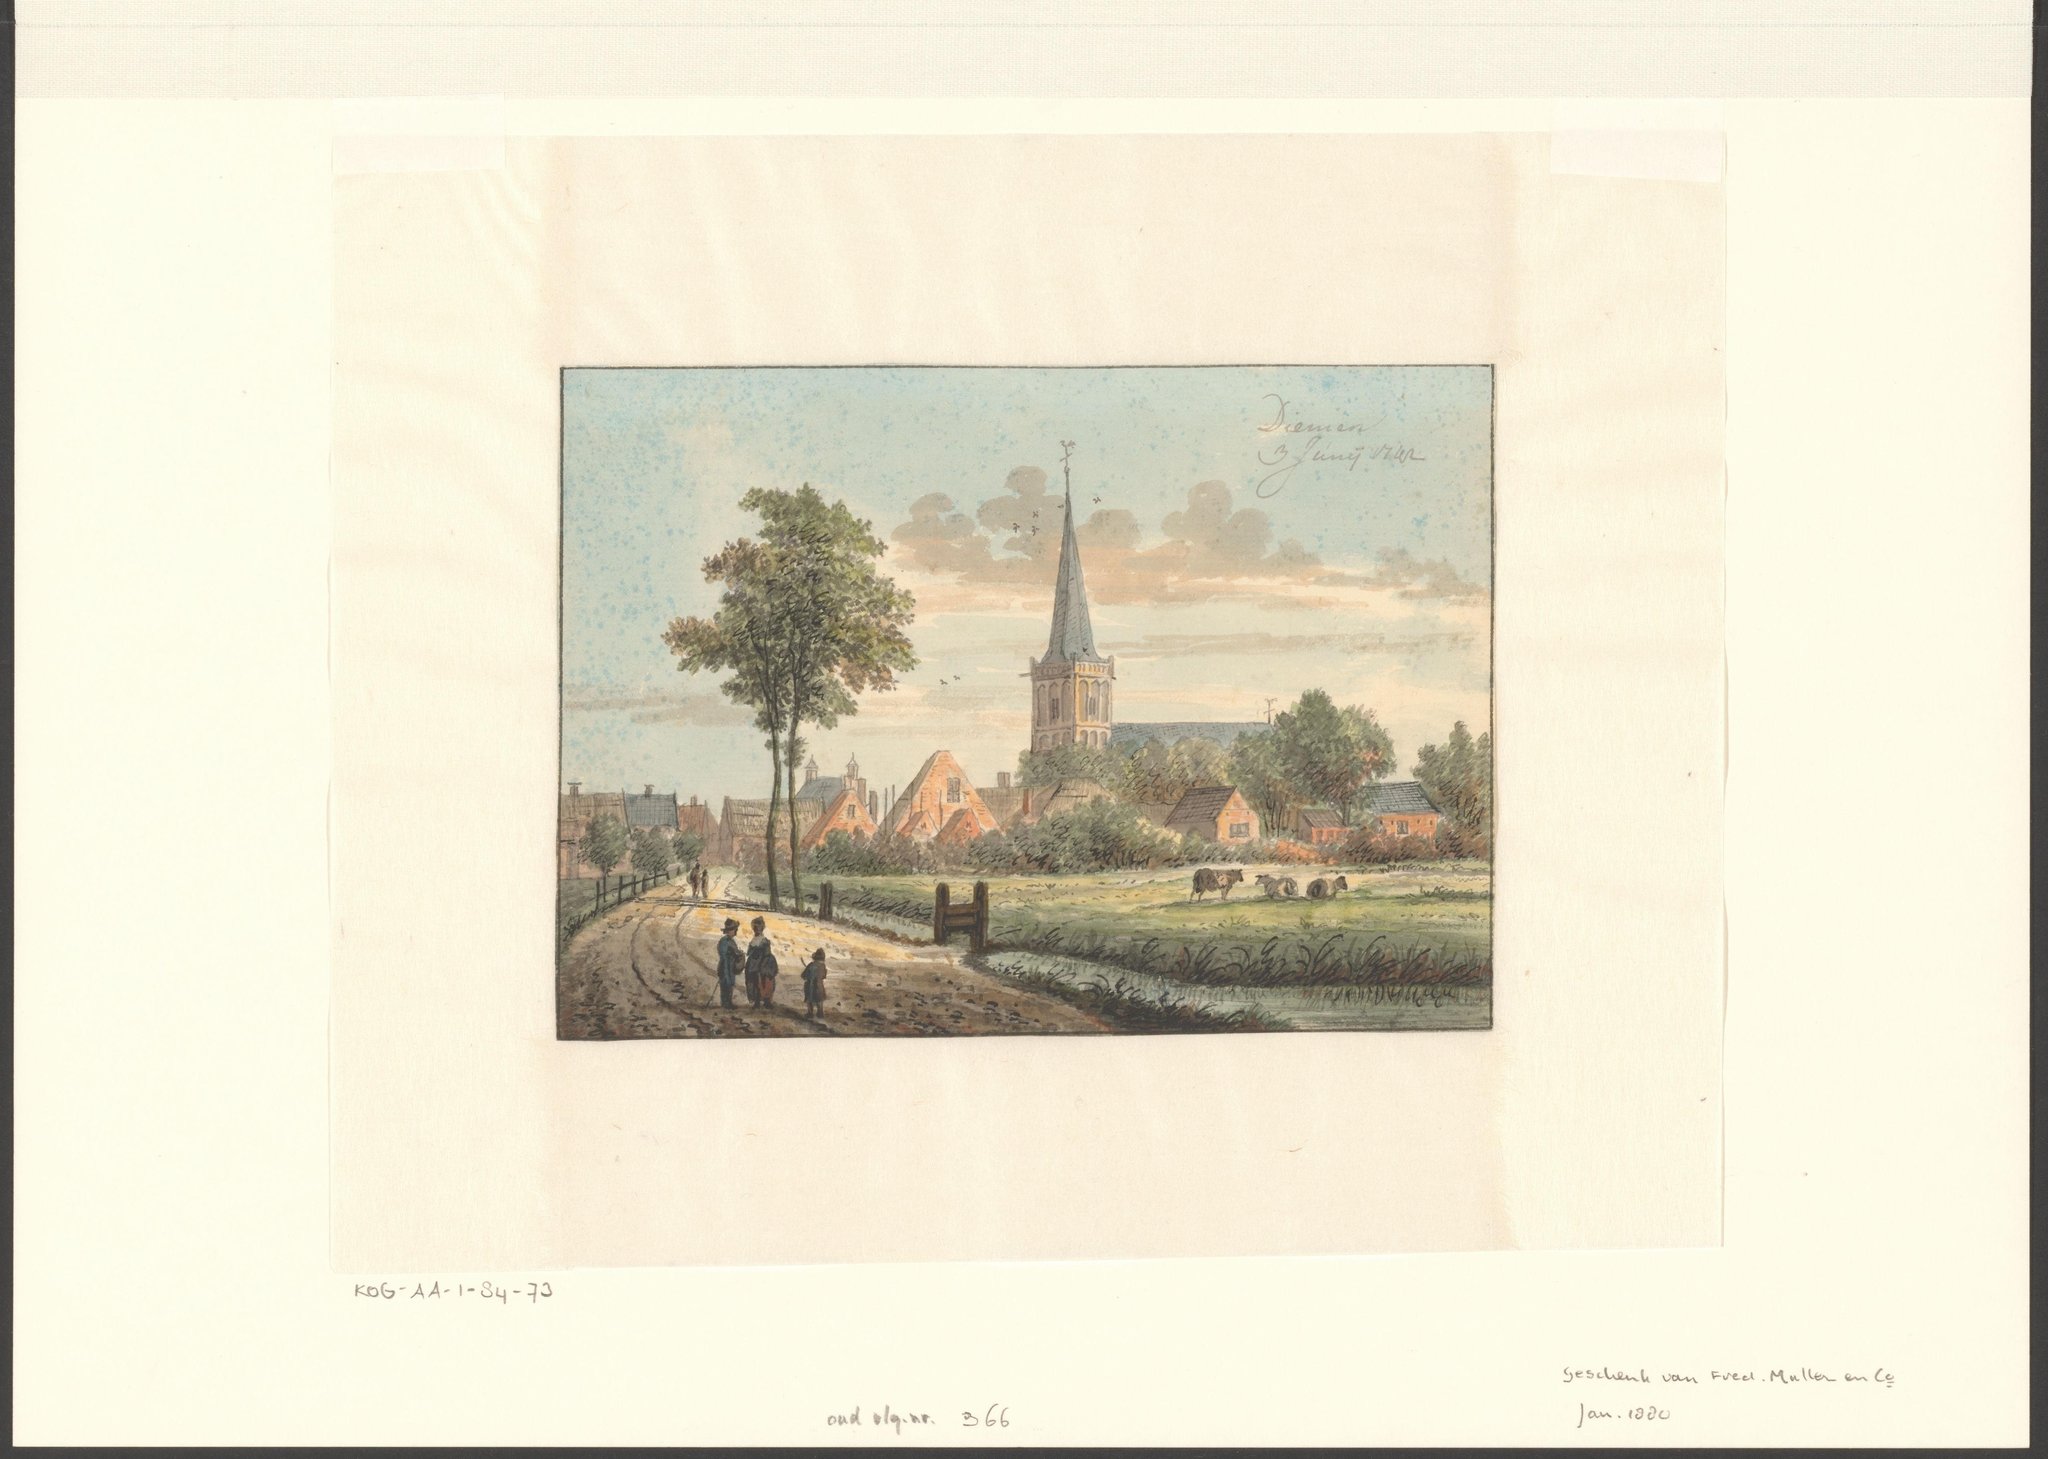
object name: drawing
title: Gezicht op Diemen vanuit het zuidwesten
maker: Anonymous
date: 1742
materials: ink, paper, pencil, watercolor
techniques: brush, pen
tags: village, road, path, parts of church exterior and annexes: spire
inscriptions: inscription: ‘Geschenk van Fred. Muller en Co / Jan. 1880’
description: Onderwerpsrubriek binnen de Atlas Amsterdam: Diemen (Oud). Diemerbrug.